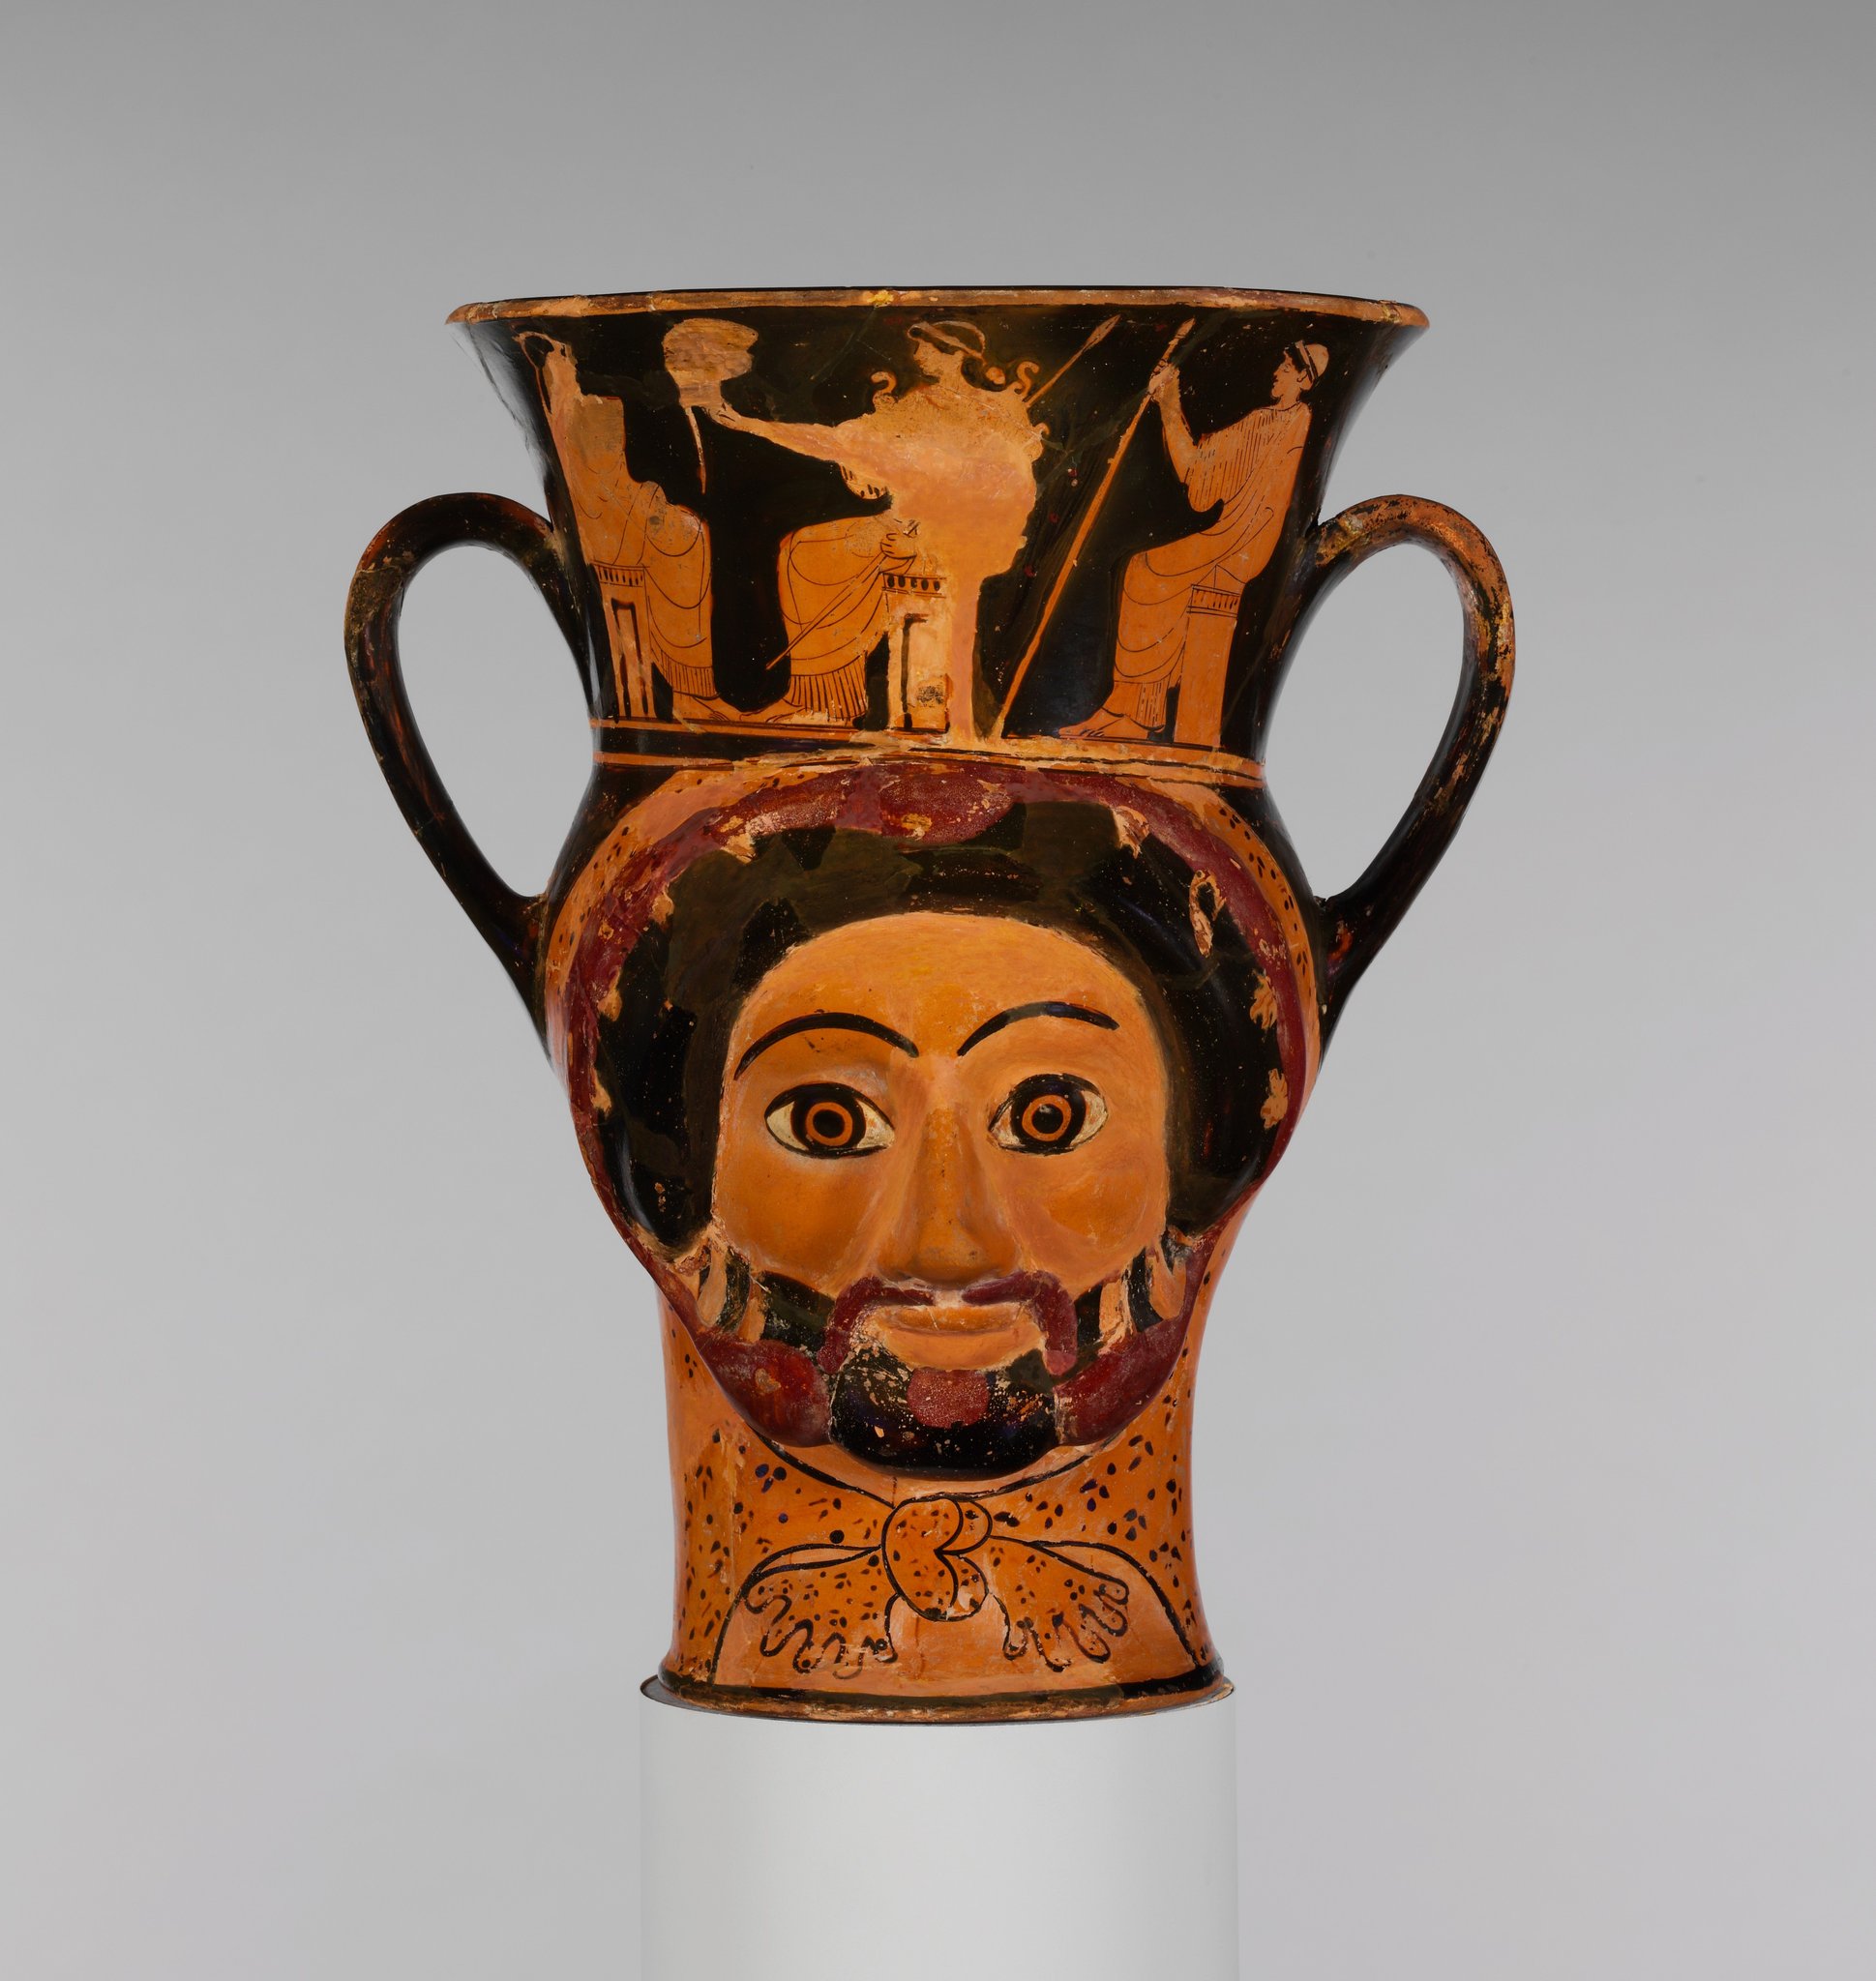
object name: kantharos in the form of two head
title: Terracotta kantharos (drinking cup) in the form of the heads of Herakles and of a woman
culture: greek, attic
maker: syriskos painter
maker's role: artist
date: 470 BCE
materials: terracotta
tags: heads,women,herakles